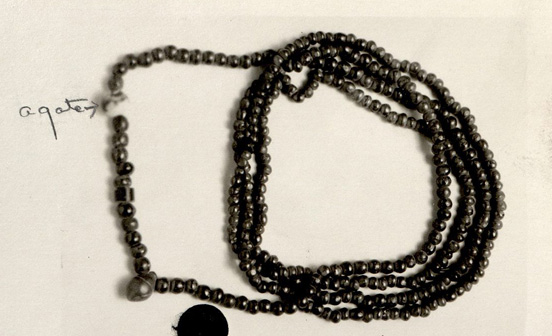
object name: necklace, bead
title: Ball bead necklace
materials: stone, gemstone